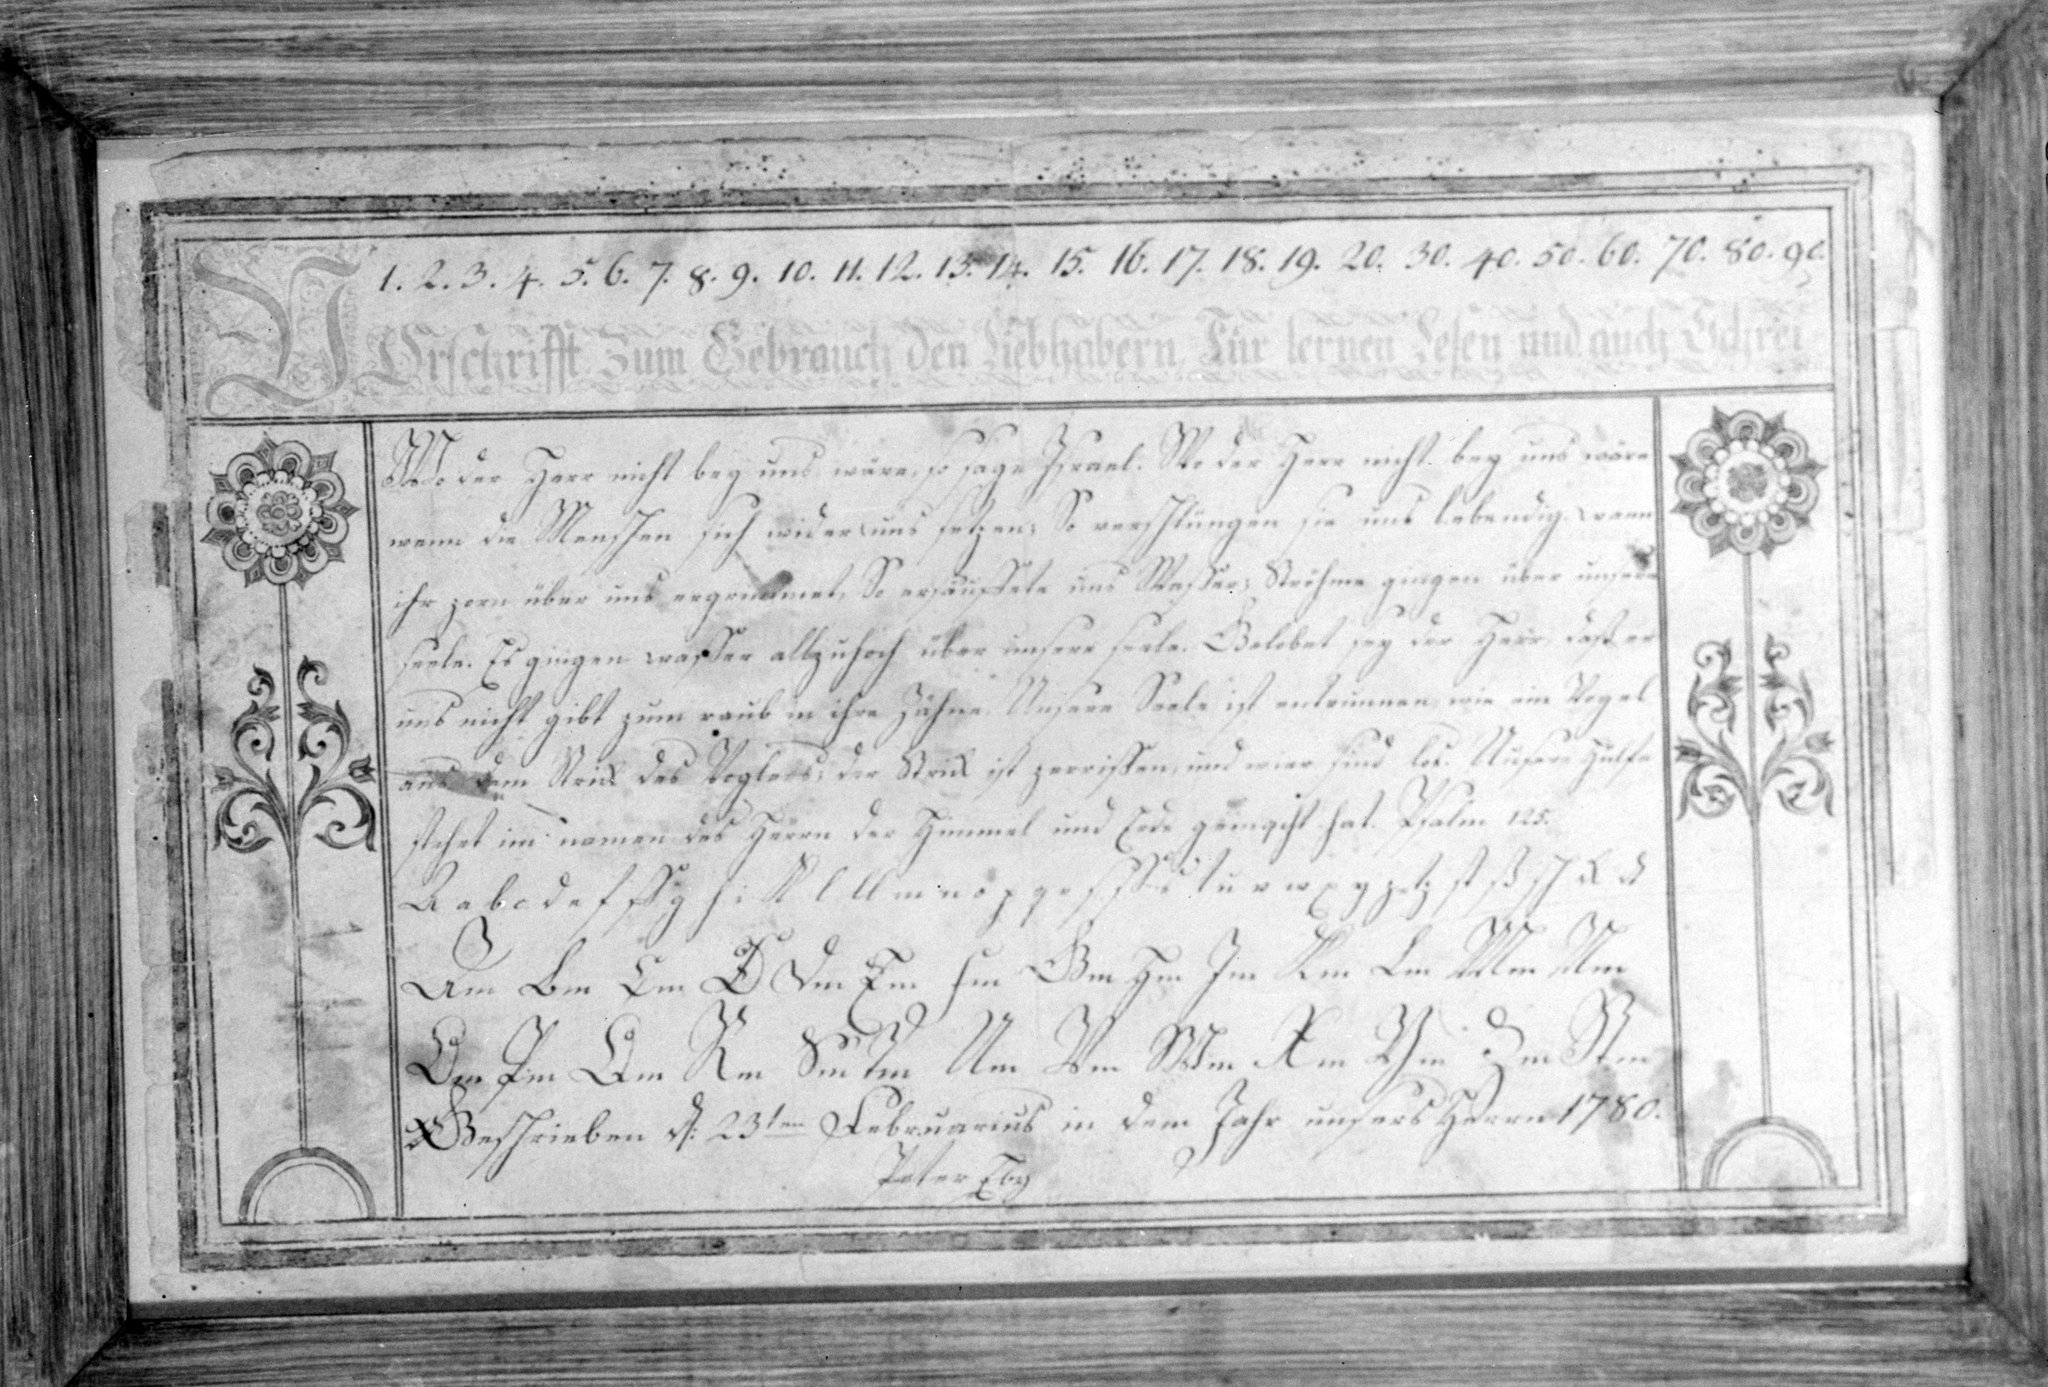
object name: manuscript sampler, fraktur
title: Manuscript Sampler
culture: american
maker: peter eby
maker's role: maker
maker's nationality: american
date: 1780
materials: ink, paper, watercolor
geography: united states